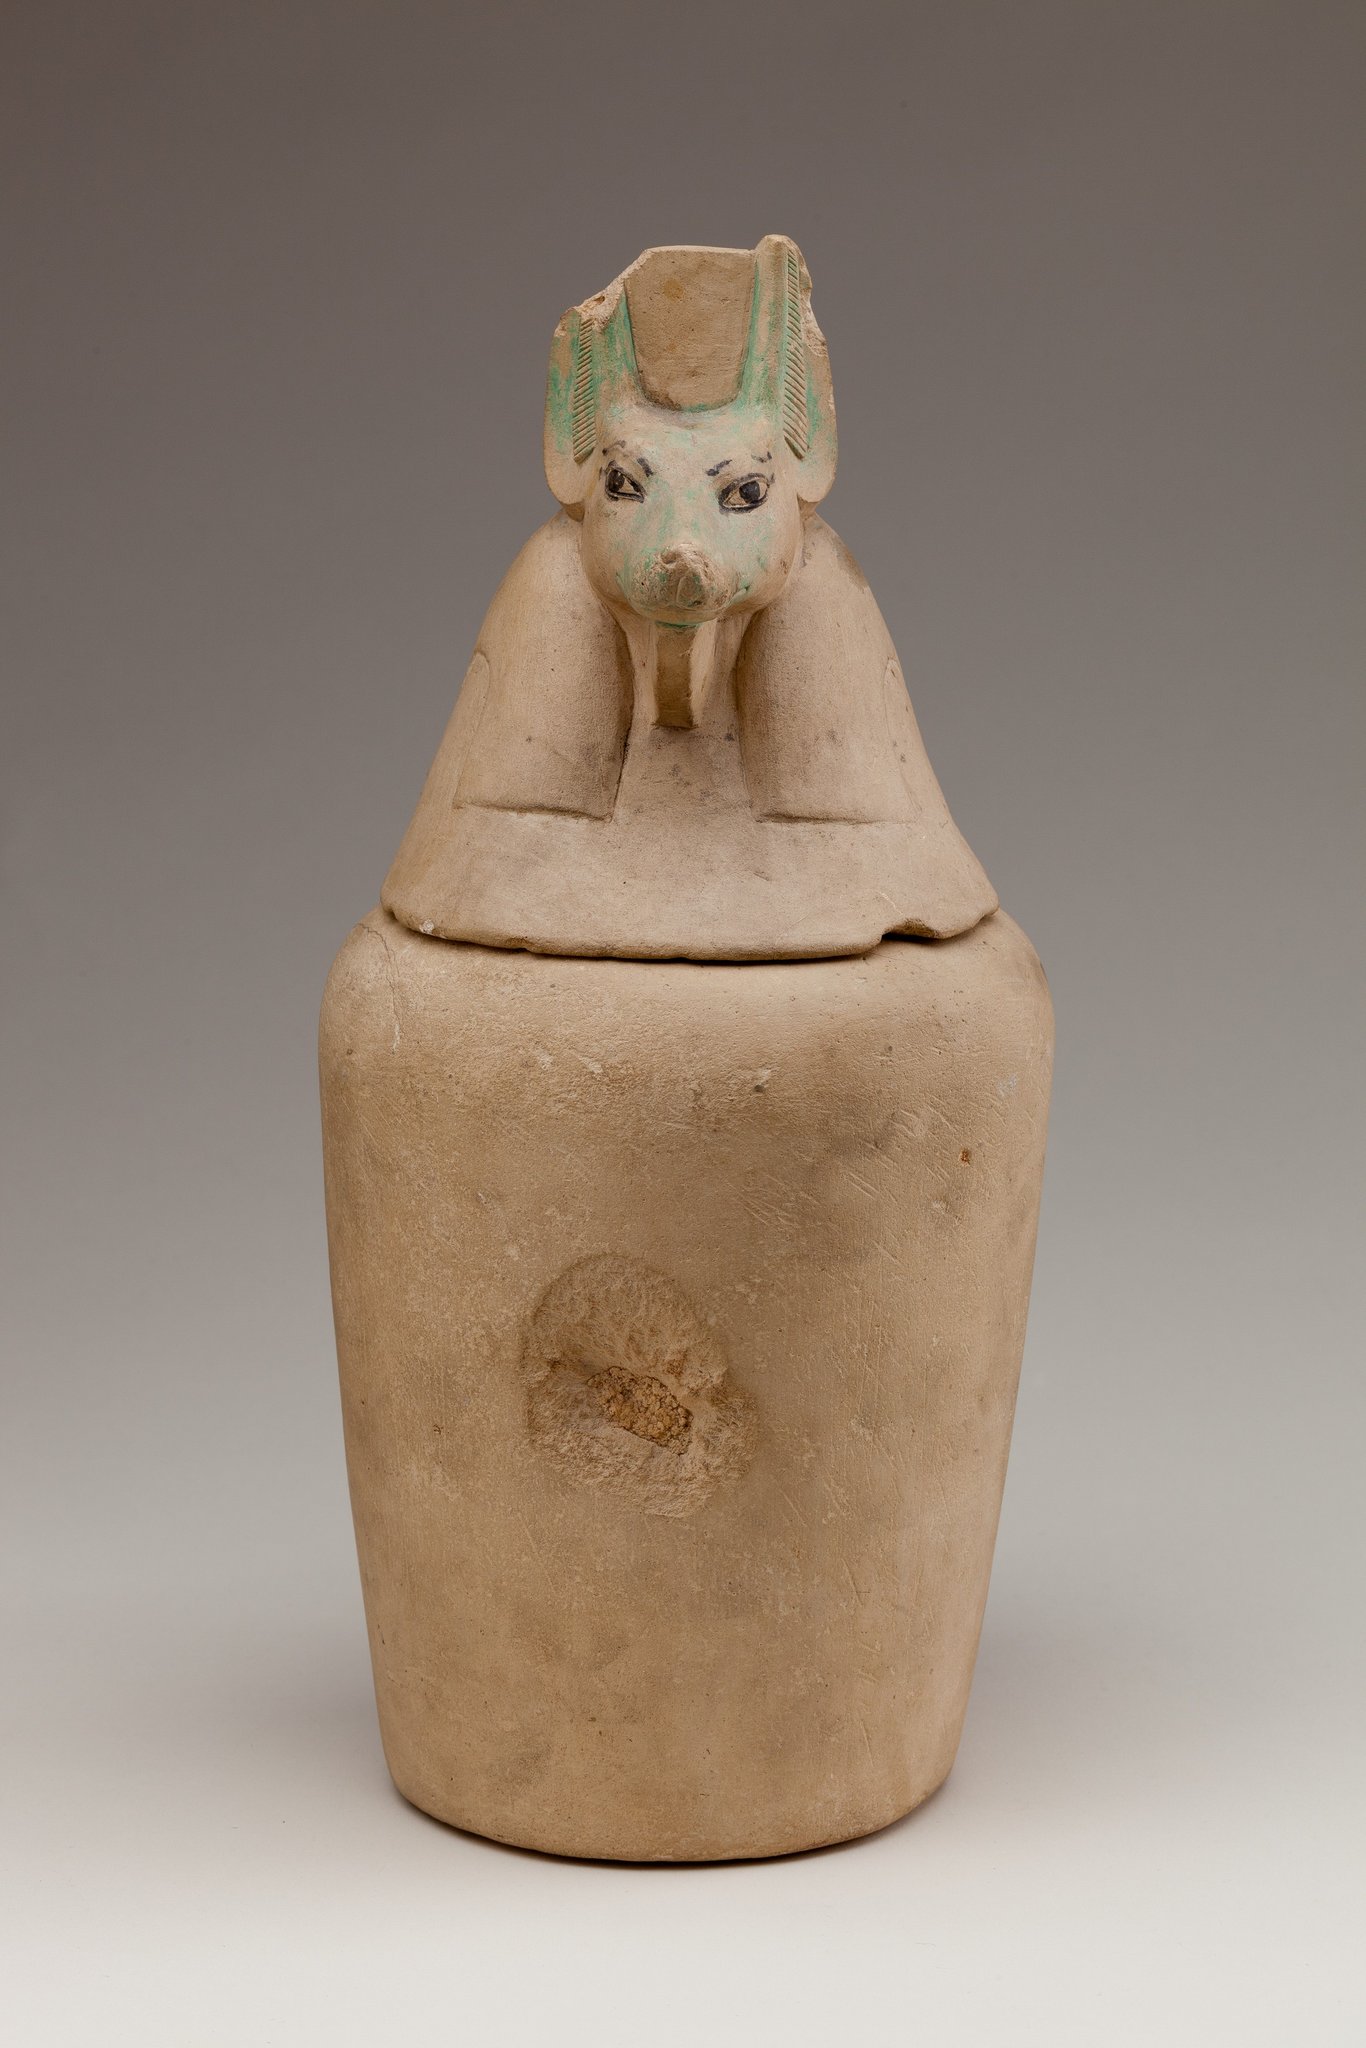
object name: canopic jar, baboon, duamutef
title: Canopic Jar Representing the Deity Duamutef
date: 664-525 BCE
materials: limestone, paint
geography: northern upper egypt